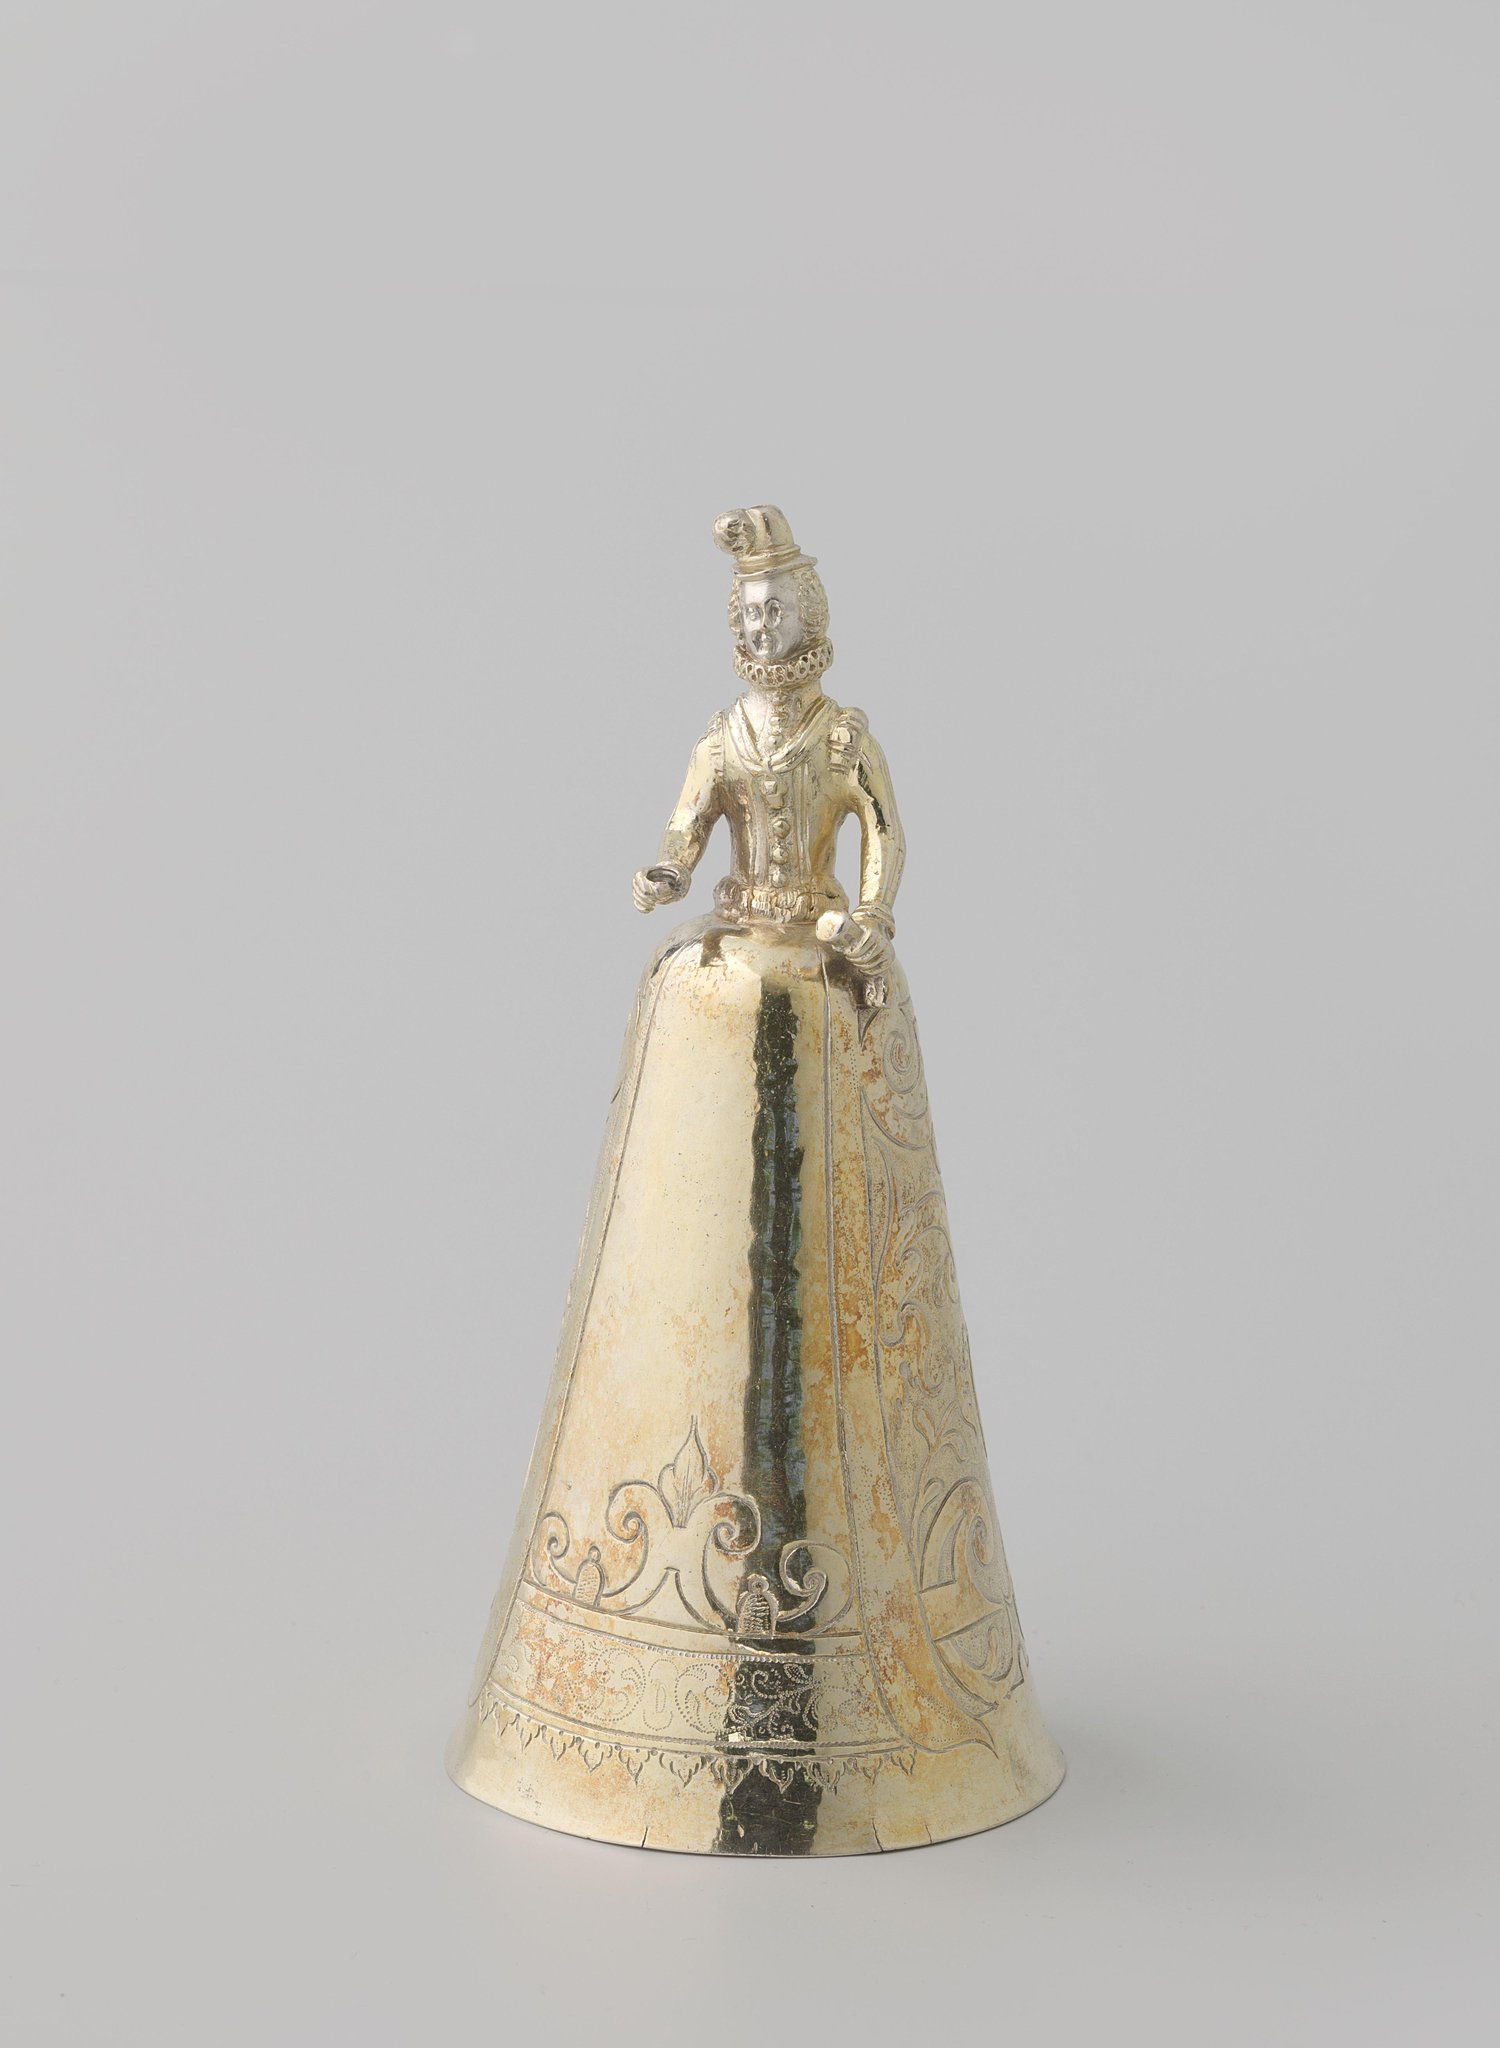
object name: cup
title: Frauenbecher van verguld zilver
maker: Anonymous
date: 1600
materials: silver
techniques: gilding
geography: nuremberg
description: Frauenbecher van verguld zilver in de vorm van een vrouwenfiguur. De uitstaande rok dient als drinkkelk.